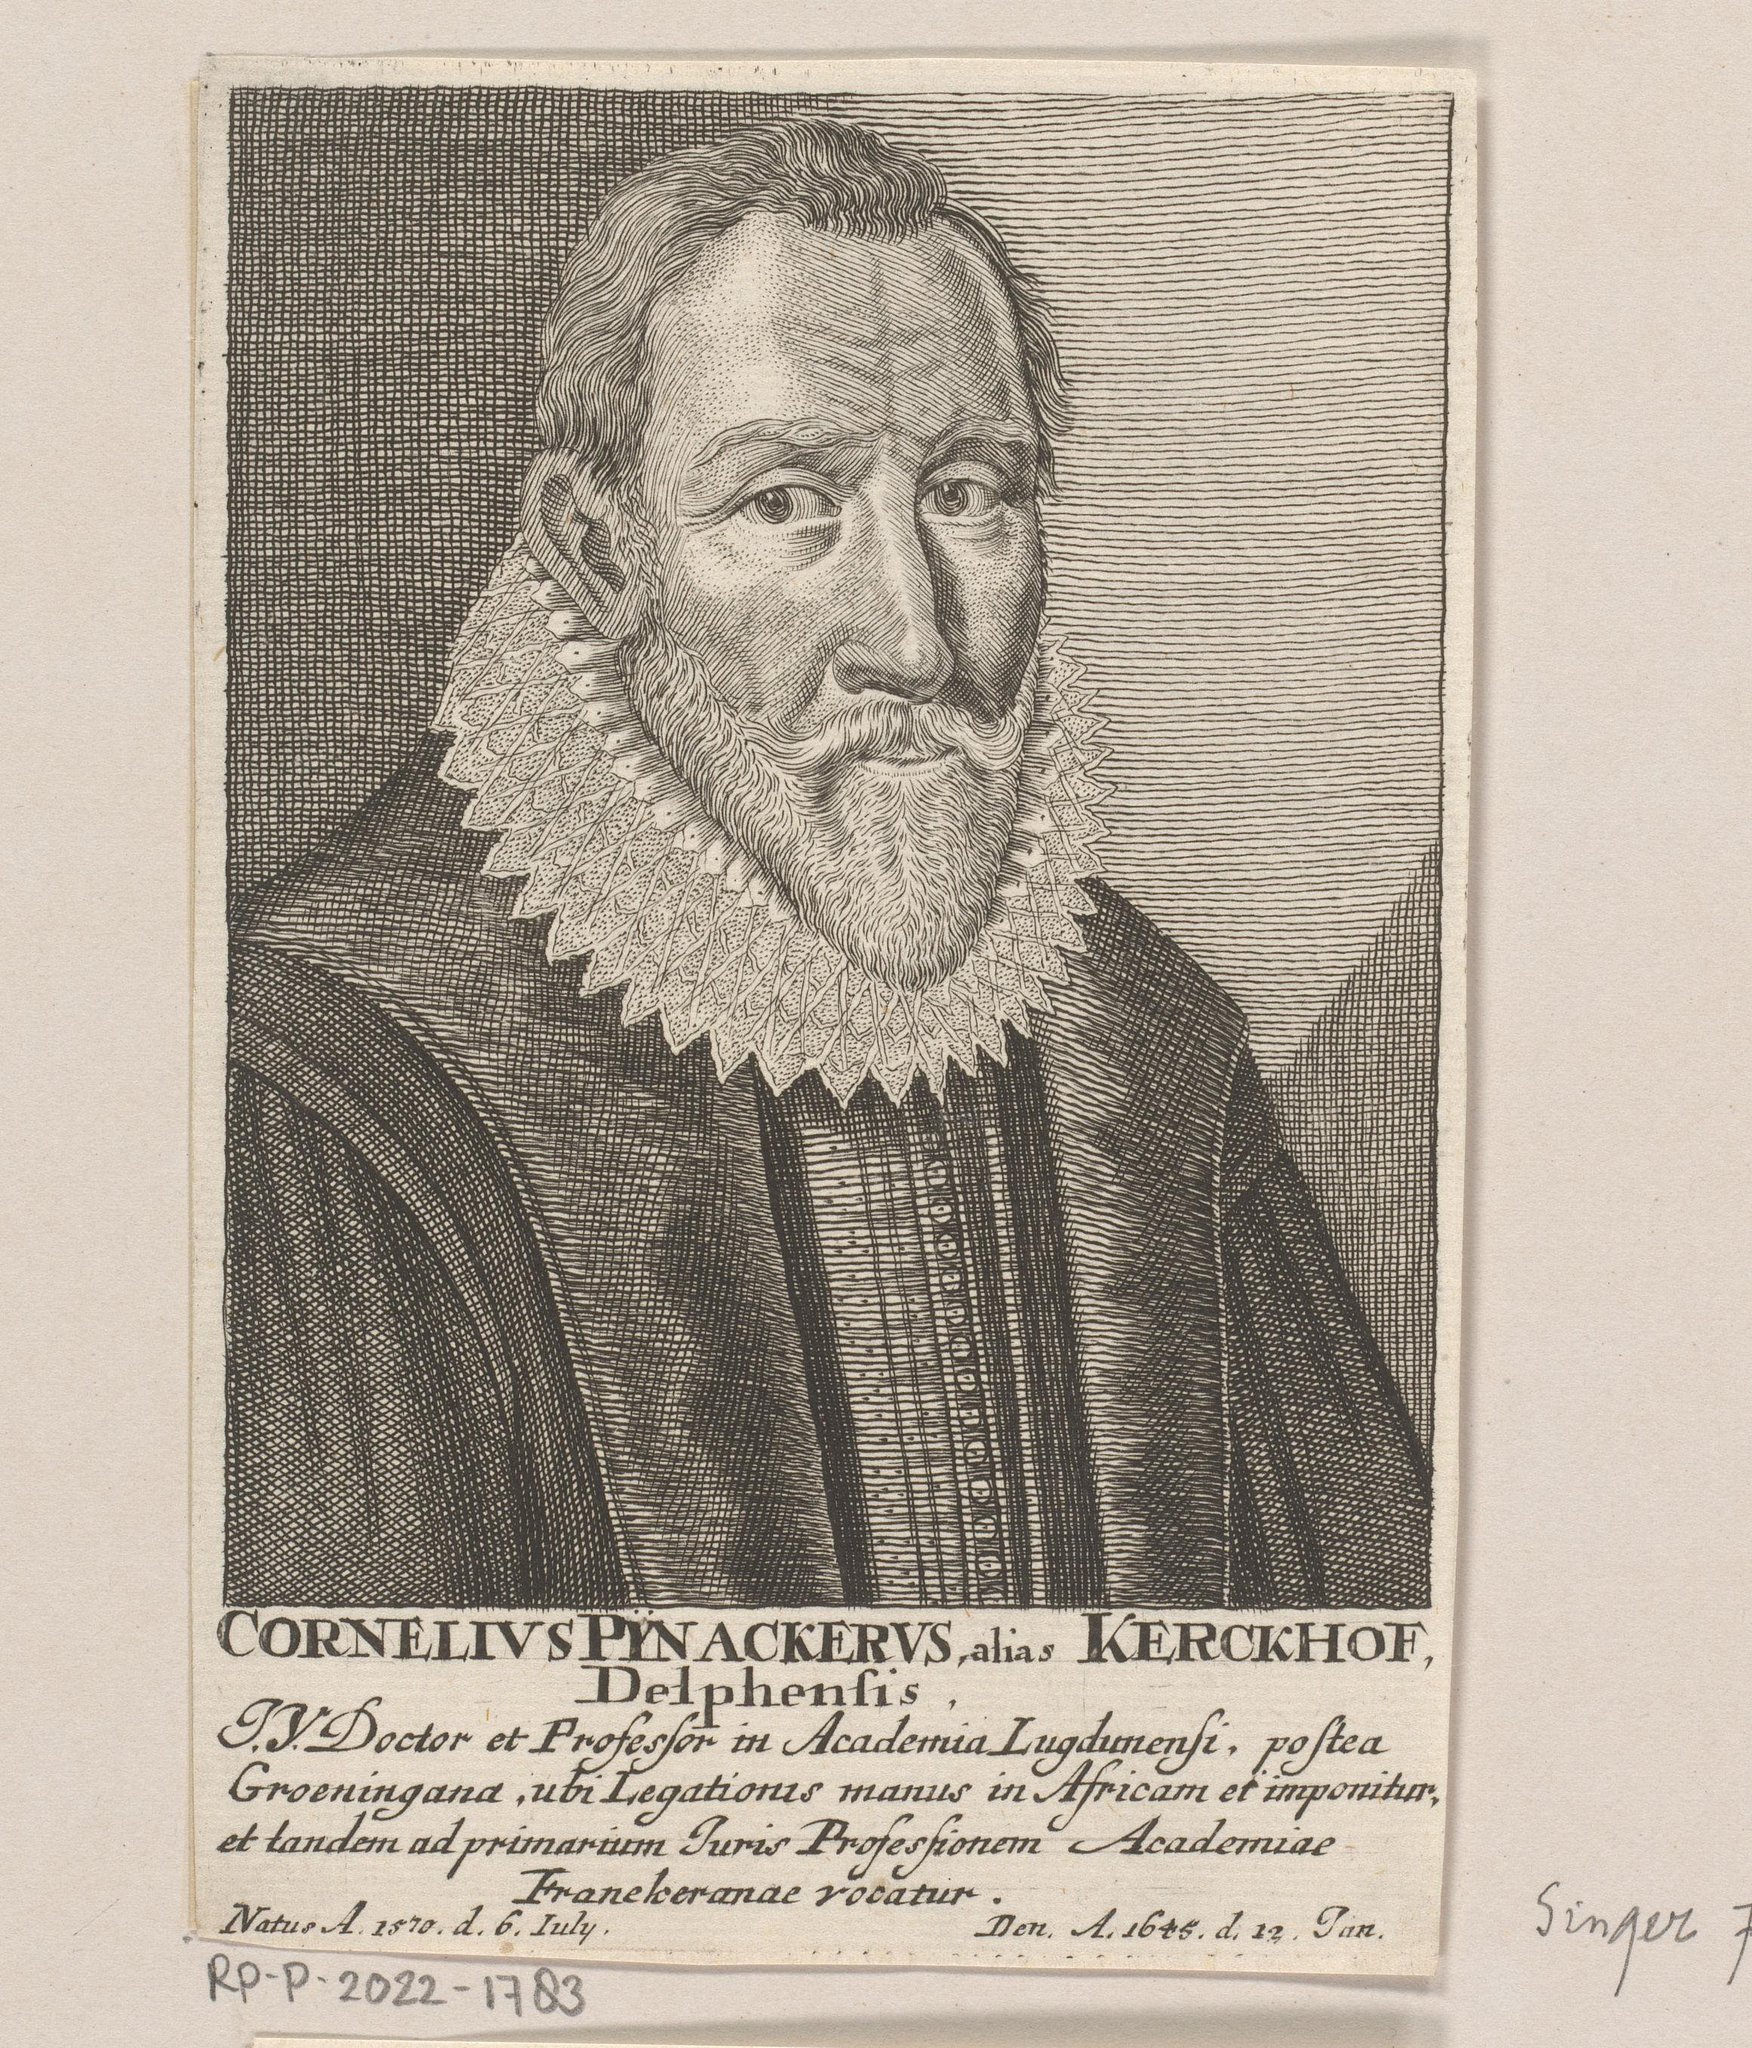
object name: print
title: Portret van Cornelis Pijnacker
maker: Anonymous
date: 1725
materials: paper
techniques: engraving, etching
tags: cornelis pijnacker, historical persons, professor, map making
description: Prent uit: Rothscholtz, Friedrich. Icones virorum omnium ordinum eruditione: omnique item genere et varietate artium de republica litteraria et speciatim de Academiis et Gymnasiis (...). Neurenberg: erven Johann Daniel Tauber, 1725, dl. 1 of 2.